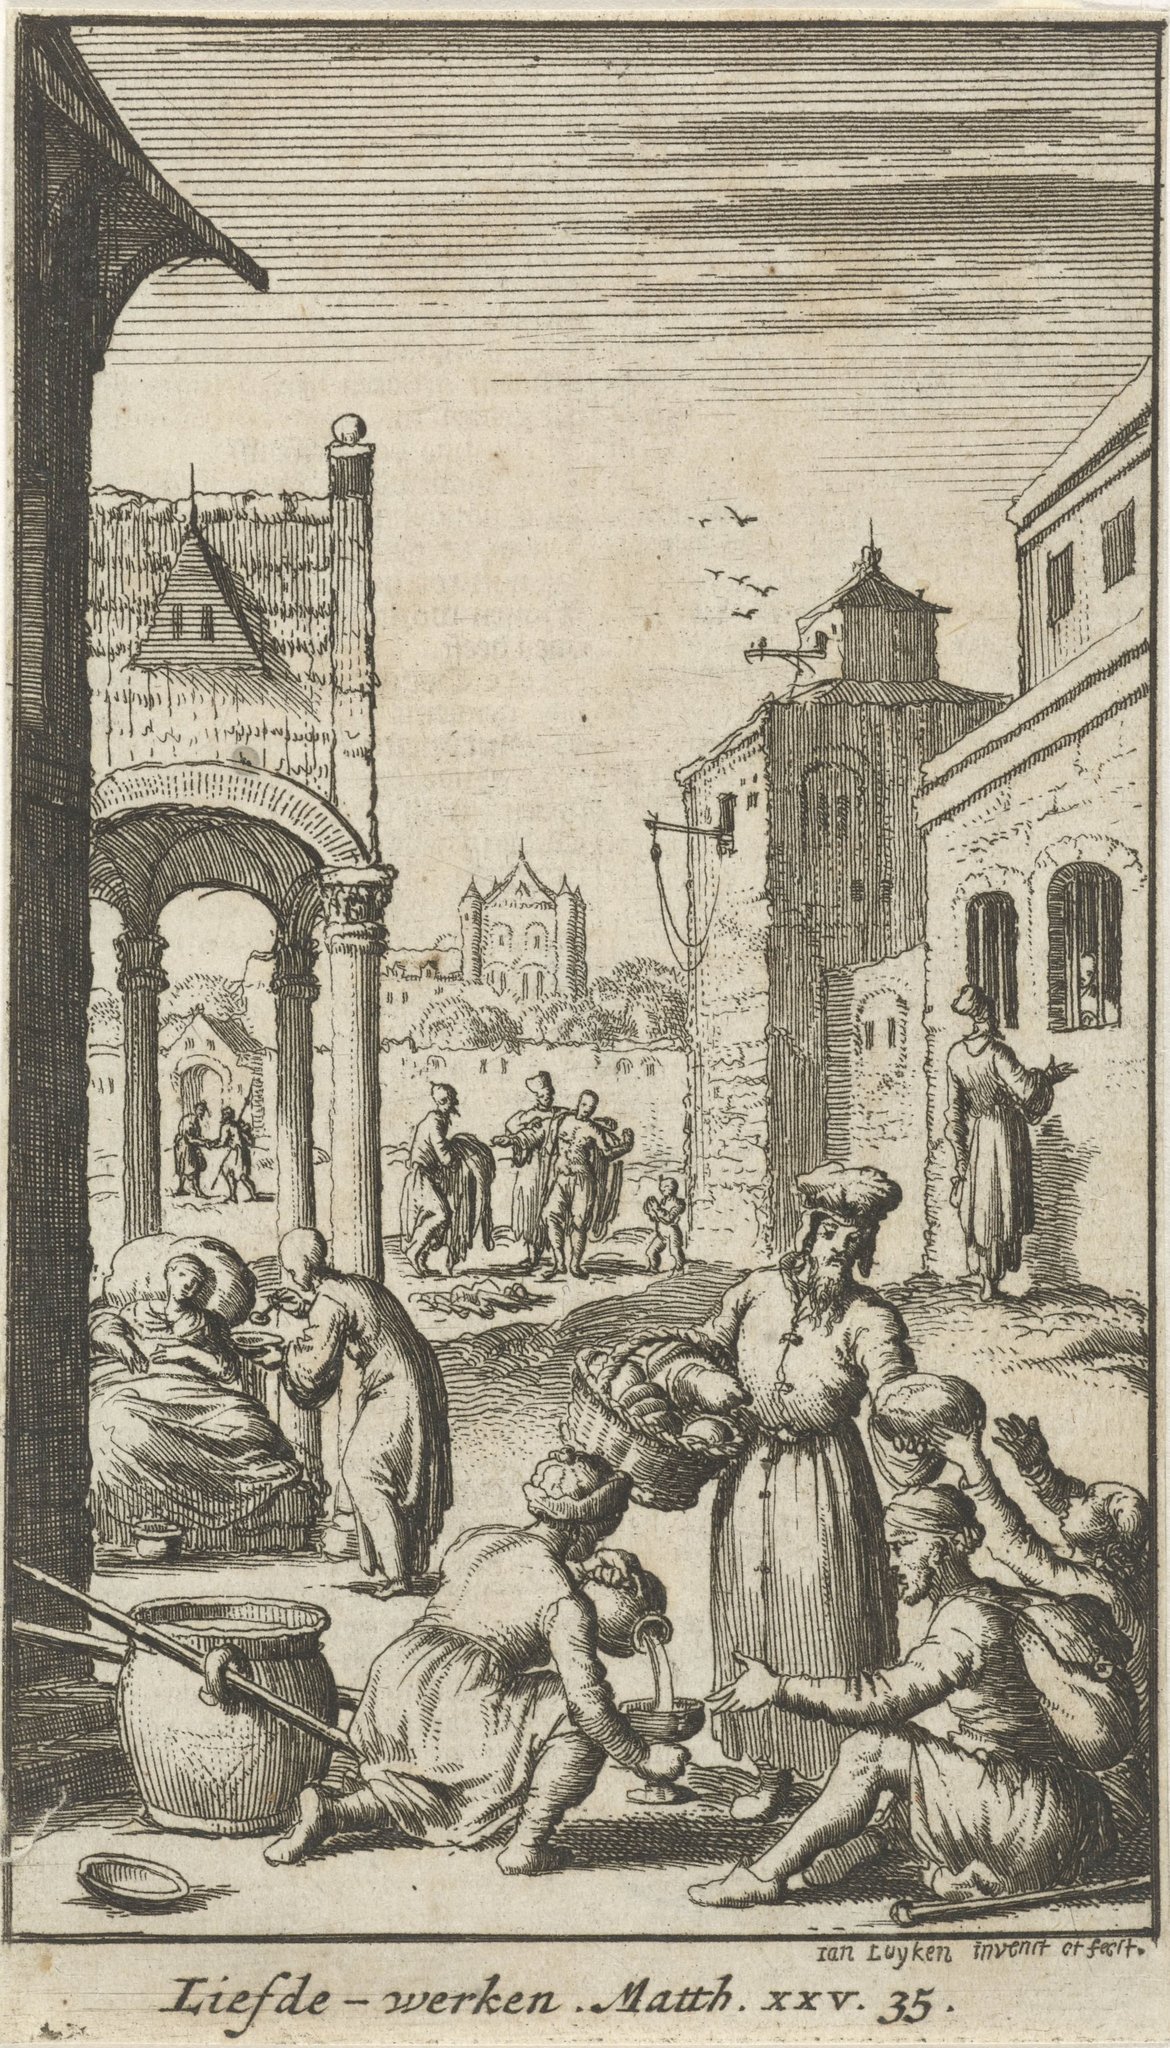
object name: book illustration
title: Liefde-werken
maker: jan luyken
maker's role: draughtsman, print maker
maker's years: 1649-1712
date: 1681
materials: paper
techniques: etching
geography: amsterdam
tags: the wise and the foolish virgins ~ parable of christ (matthew 25:1-13)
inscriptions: collector's mark: Lugt 2228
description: Twintig prenten van deze serie (waaronder de hier besproken prent) verschenen mogelijk voor het eerst in: Het Nieuwe Testament ofte alle Boecken des Nieuwen Verbondts onses Heeren Iesu Christi. Amsterdam: Hieronymus Sweerts, Jan ten Hoorn, Jan Bouman en Daniel van den Dalen, 1681. De complete vierentwintigdelige serie prenten is opgenomen in: Het Nieuwe Testament ofte alle Boecken des Nieuwen Verbondts onses Heeren Iesu Christi. Dordrecht: Pieter en Jacob Keur, 172X (niet voor 1727). De prenten werden, hetzij alle tezamen, hetzij gedeeltelijk, veel gebruikt tot versiering van Nieuwe Testamenten en verschenen tevens in kopie.